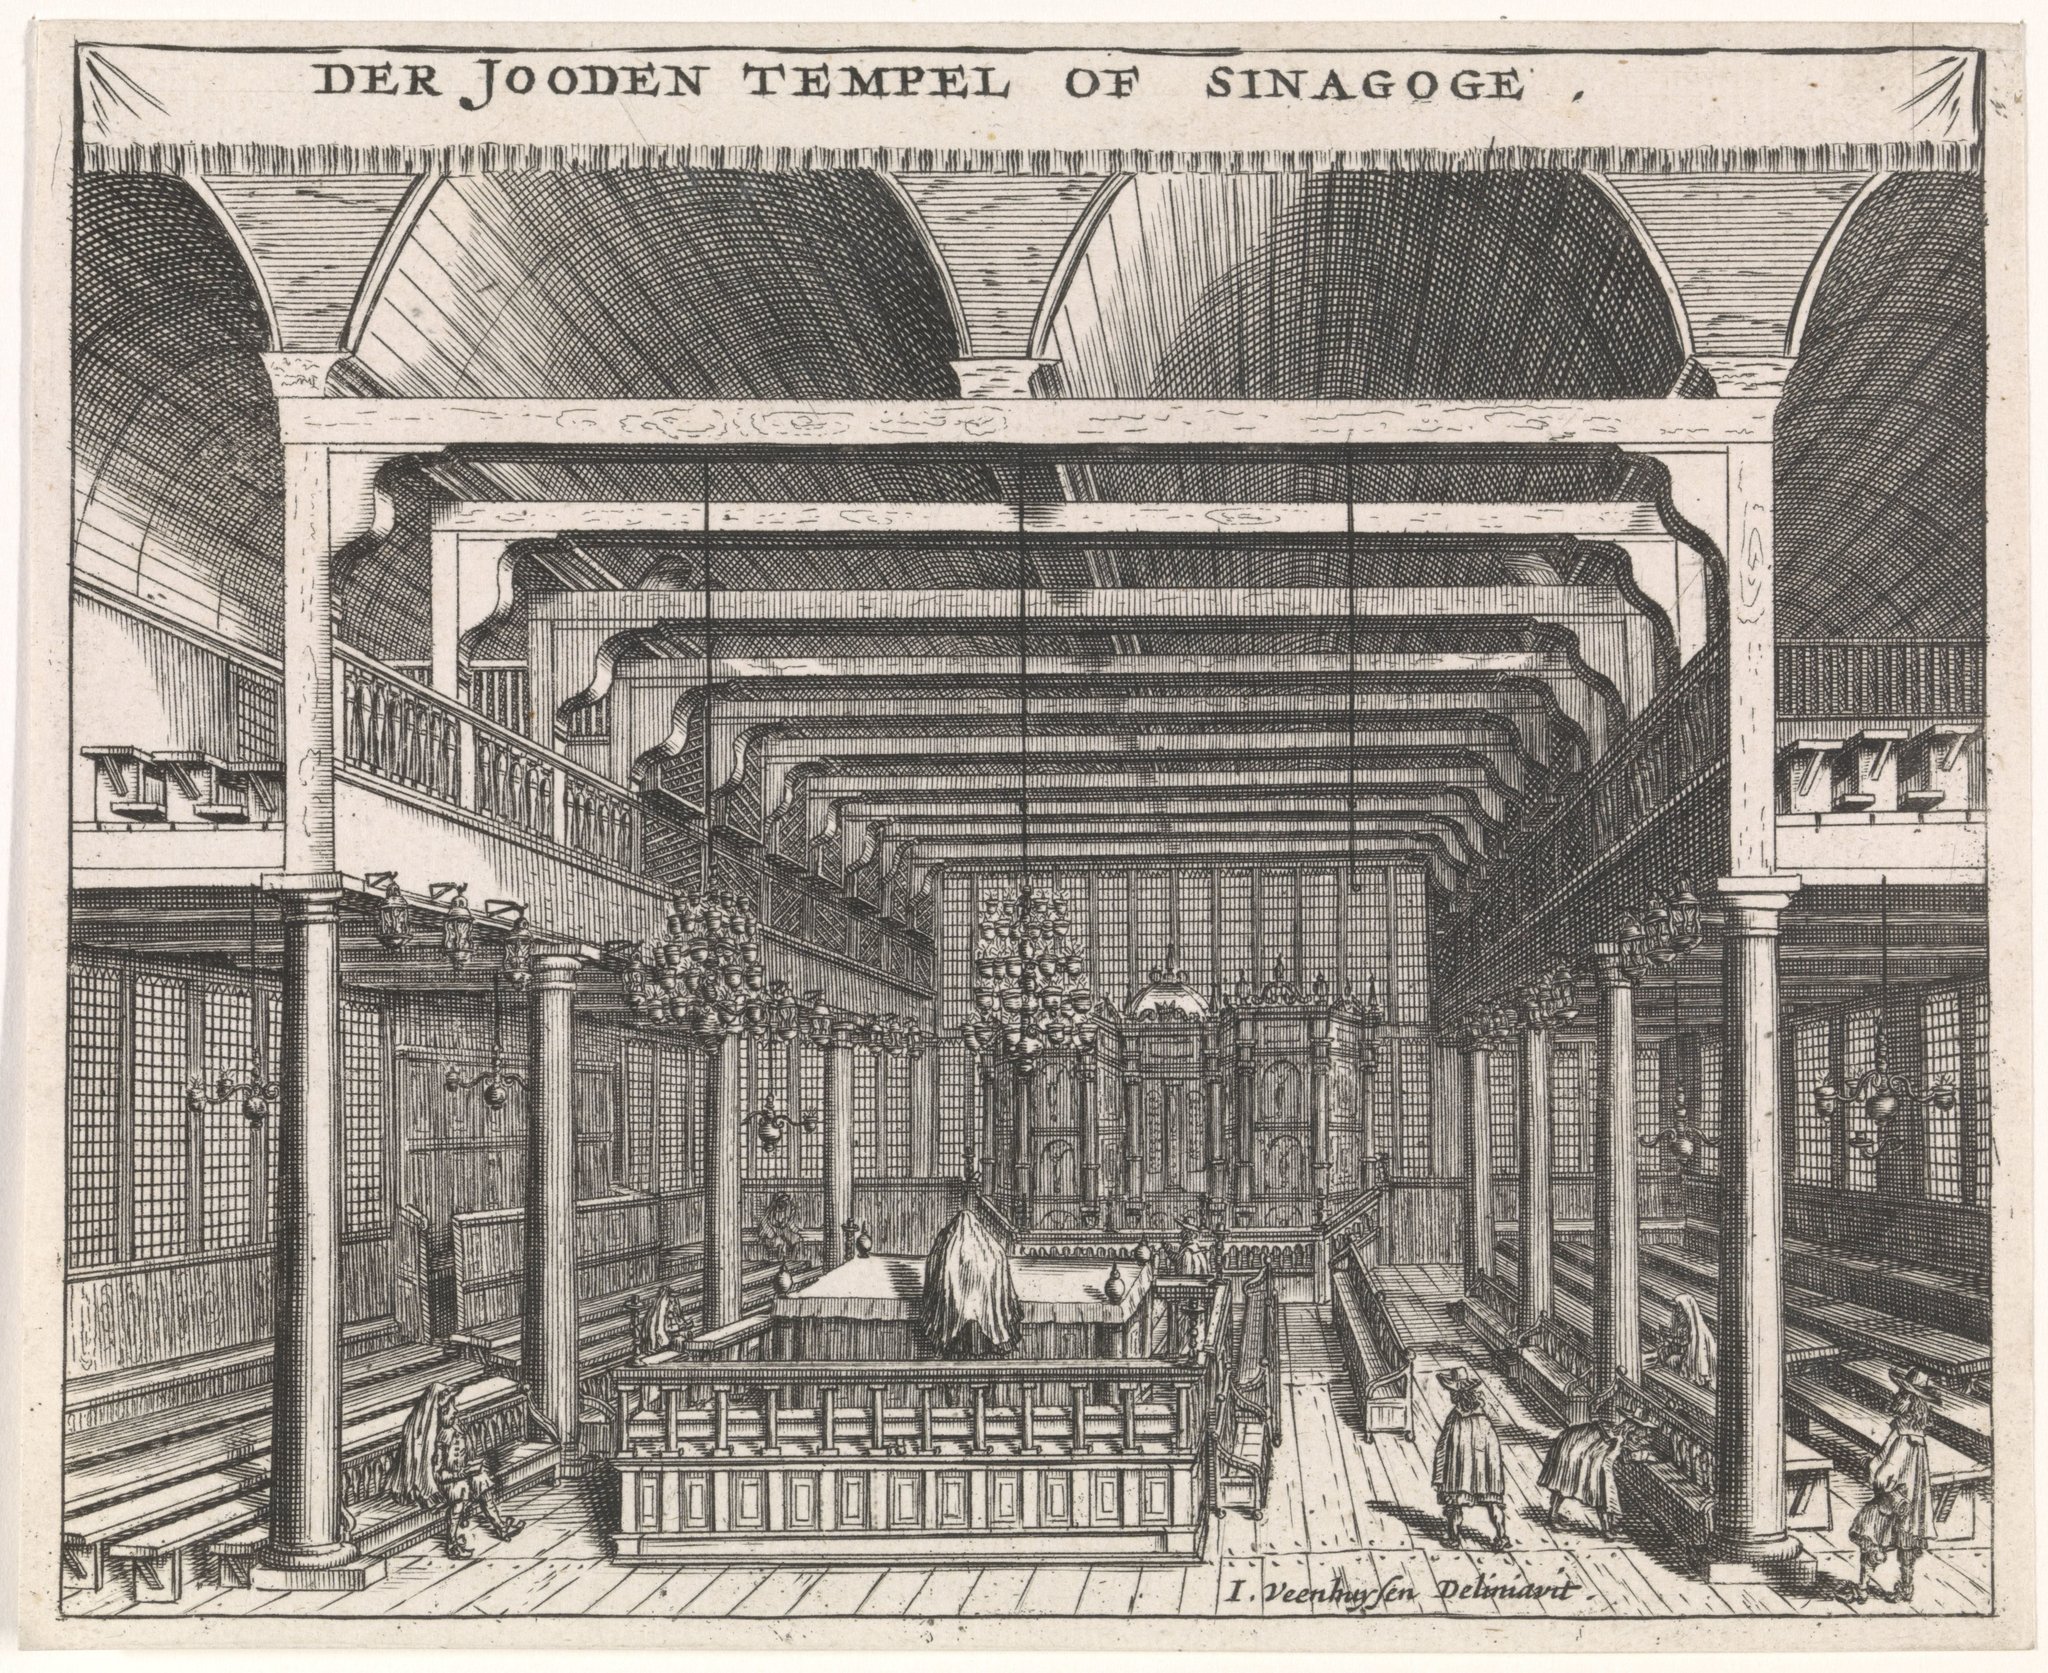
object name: print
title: Der Jooden Tempel of Sinagoge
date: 1664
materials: paper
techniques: engraving, etching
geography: amsterdam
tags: 'sephardim' ~ jewish communities, the synagogue (as building and place of worship ~ jewish religion)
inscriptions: collector's mark: Lugt 195, collector's mark: Lugt 2233, inscription: ‘Op de Houtgracht’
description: Huidige staat van prent ook gebruikt in: Fockens, Melchior. Beschrijving Der wijdt-vermaarde Koop-stadt Amstelredam, Van haar eerste beginselen, zedert den Jare 1203. oude Voorrechten, verscheyde Vergrootingenoude Voor-rechten, en verscheyde Vergrootingen (…). 3e druk. Amsterdam: Marcus Willemsz. Doornick, 1664. En in: Zesen, Philipp von. Beschrybung der Weidtberuhmde Kauf-Stadt Amstelredam / Beschreibung der Stadt Amsterdam darinnen von derselben ersten ursprunge bis auf gegenwartigen zustand (…). Amsterdam: Marcus Willemsz. Doornick, 1664. Tweede bekende staat (met toevoeging Franse titel) ook gebruikt in: Domselaer, Tobias en Isaac Commelin. Beschryvinge van Amsterdam : haar eerste oorspronk uyt den huyze der heeren van Aemstel en Aemstellant (…). 6 delen. Amsterdam: Marcus Willemsz van Doornick, 1665. Derde bekende staat (rechtsboven genummerd: 25) ook gebruikt in verschillende latere zeventiende- en achttiende-eeuwse publicaties.